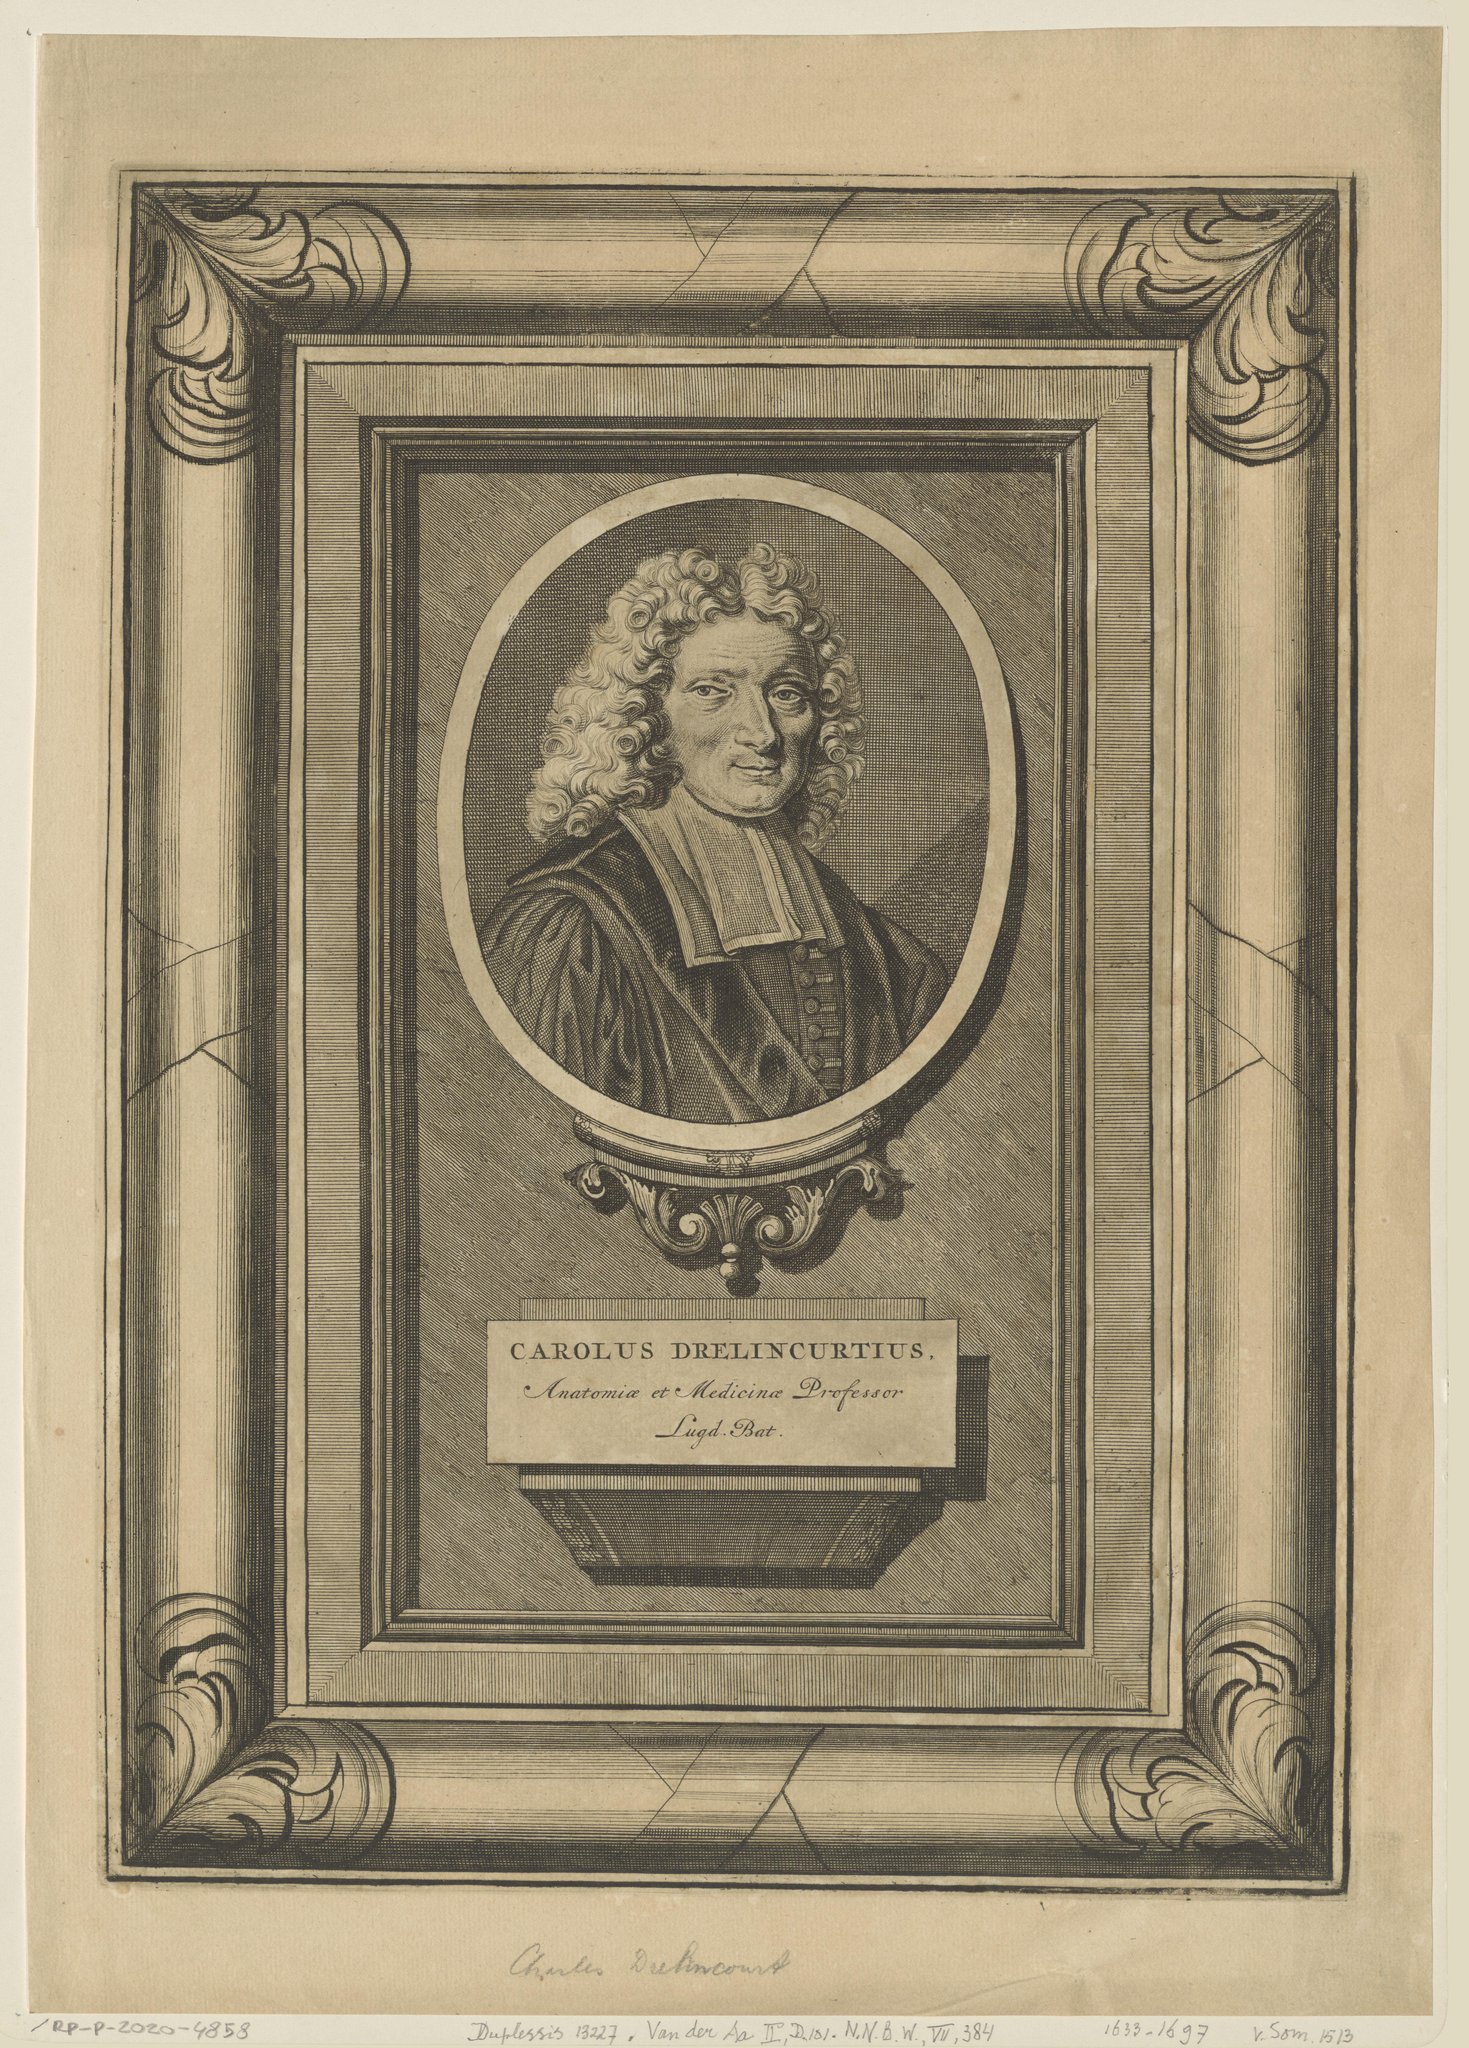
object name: print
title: Portret van Charles Drelincourt II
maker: Anonymous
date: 1716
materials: paper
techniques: engraving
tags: historical persons, physician, doctor, professor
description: Prent mogelijk uit: Fundatoris curatorum et professorum celeberrimorum, (...) academia Lugduno-Batava (...). Leiden: Pieter van der Aa, [ca. 1716].